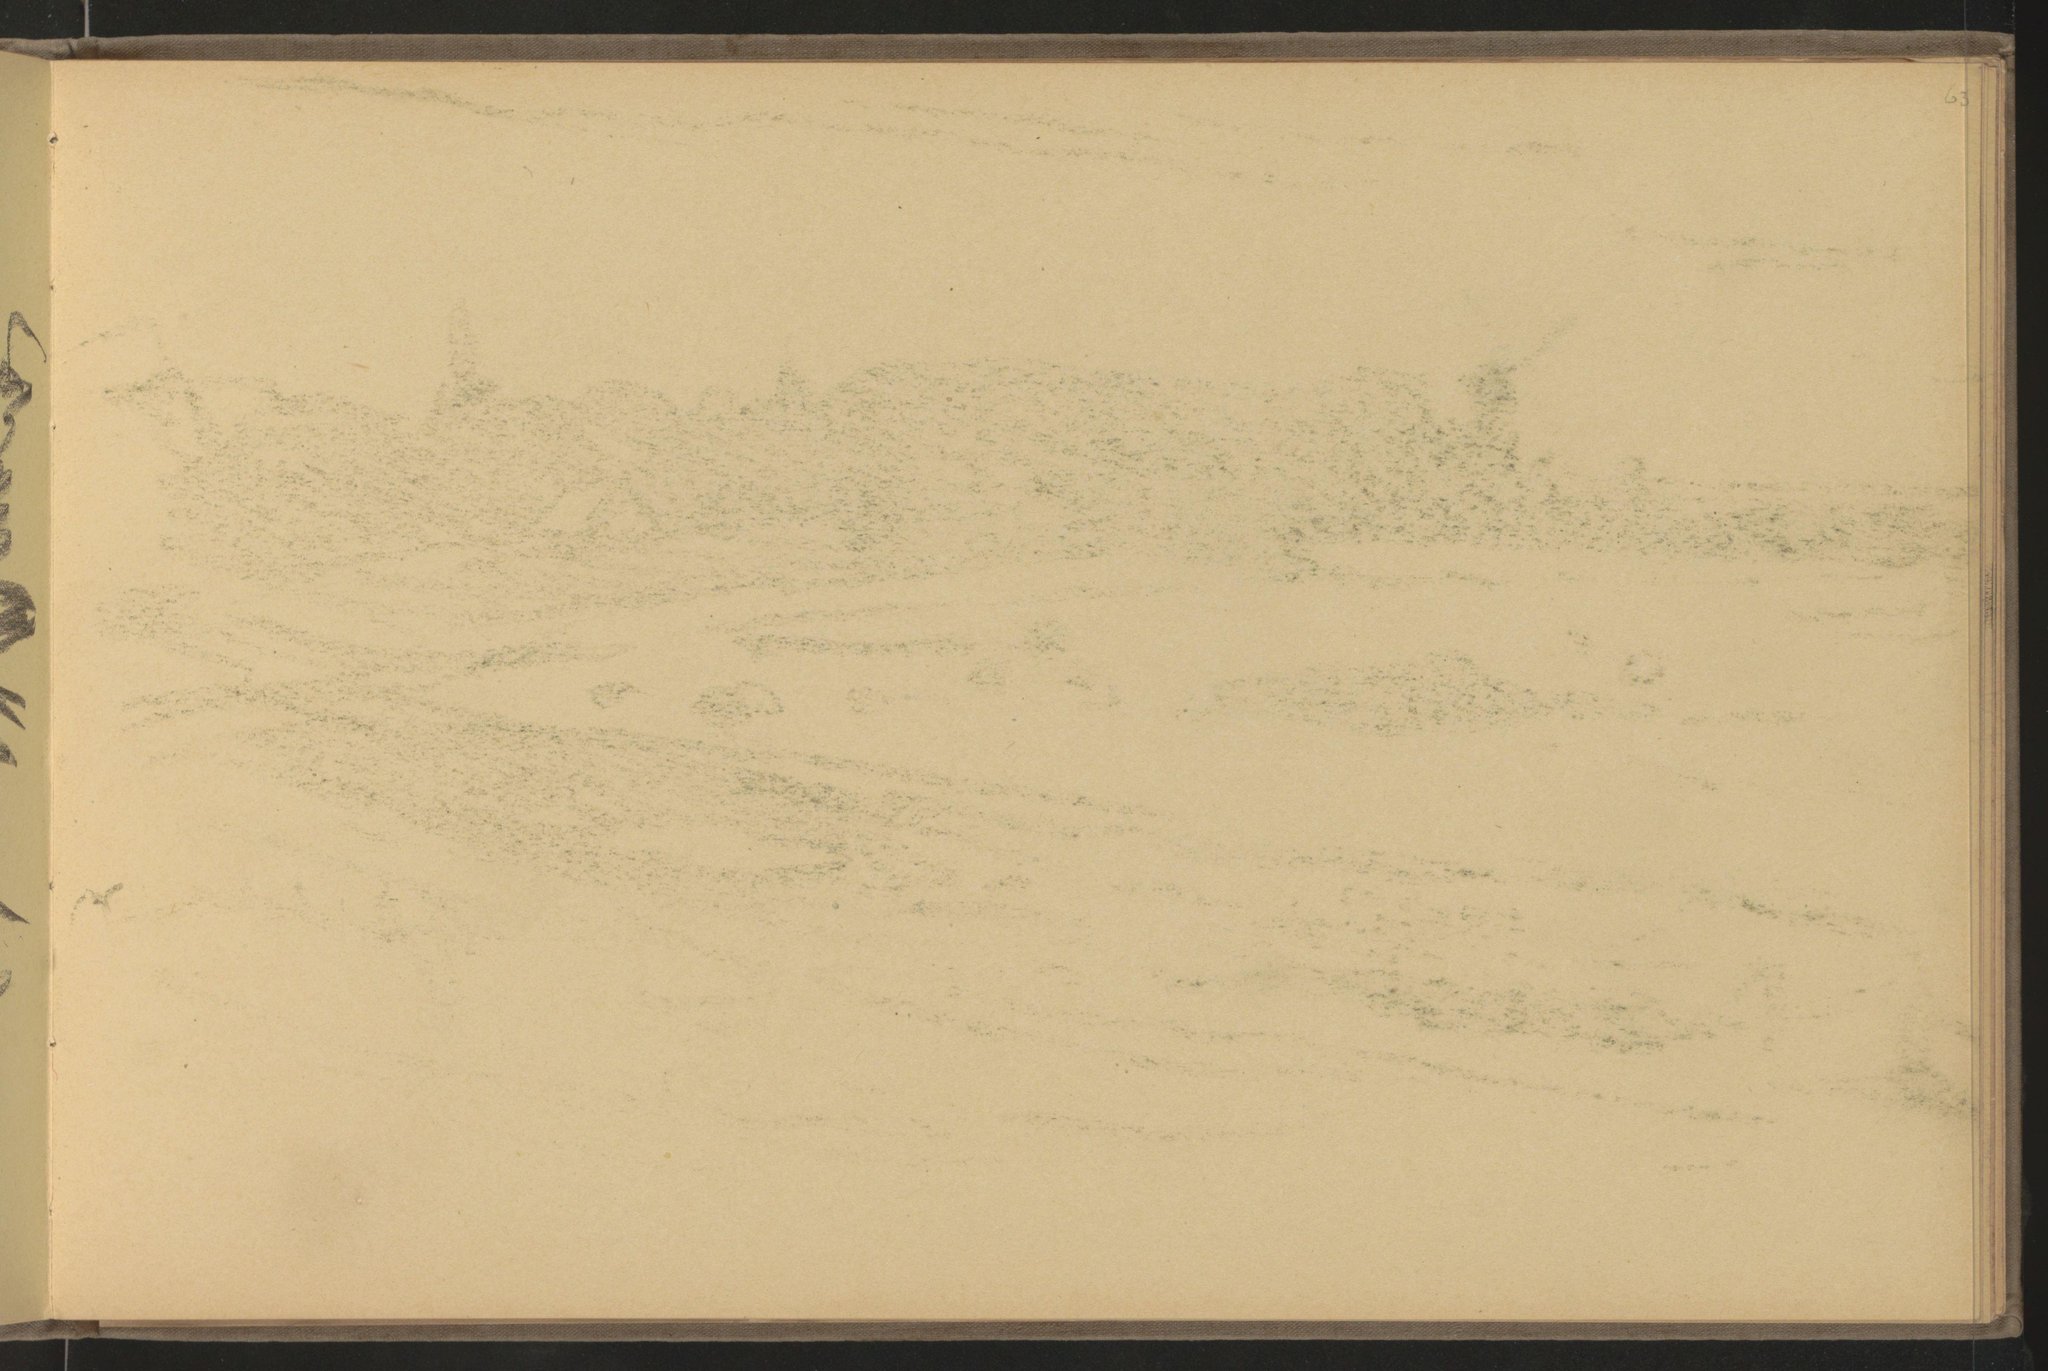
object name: sketchbook leaf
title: Abklatsch van de krijttekening op pagina 62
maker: willem witsen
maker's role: draughtsman, painter, print maker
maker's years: 1860-1923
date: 1901-1907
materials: paper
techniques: printmaking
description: Pagina 63 uit een schetsboek met 60 bladen.